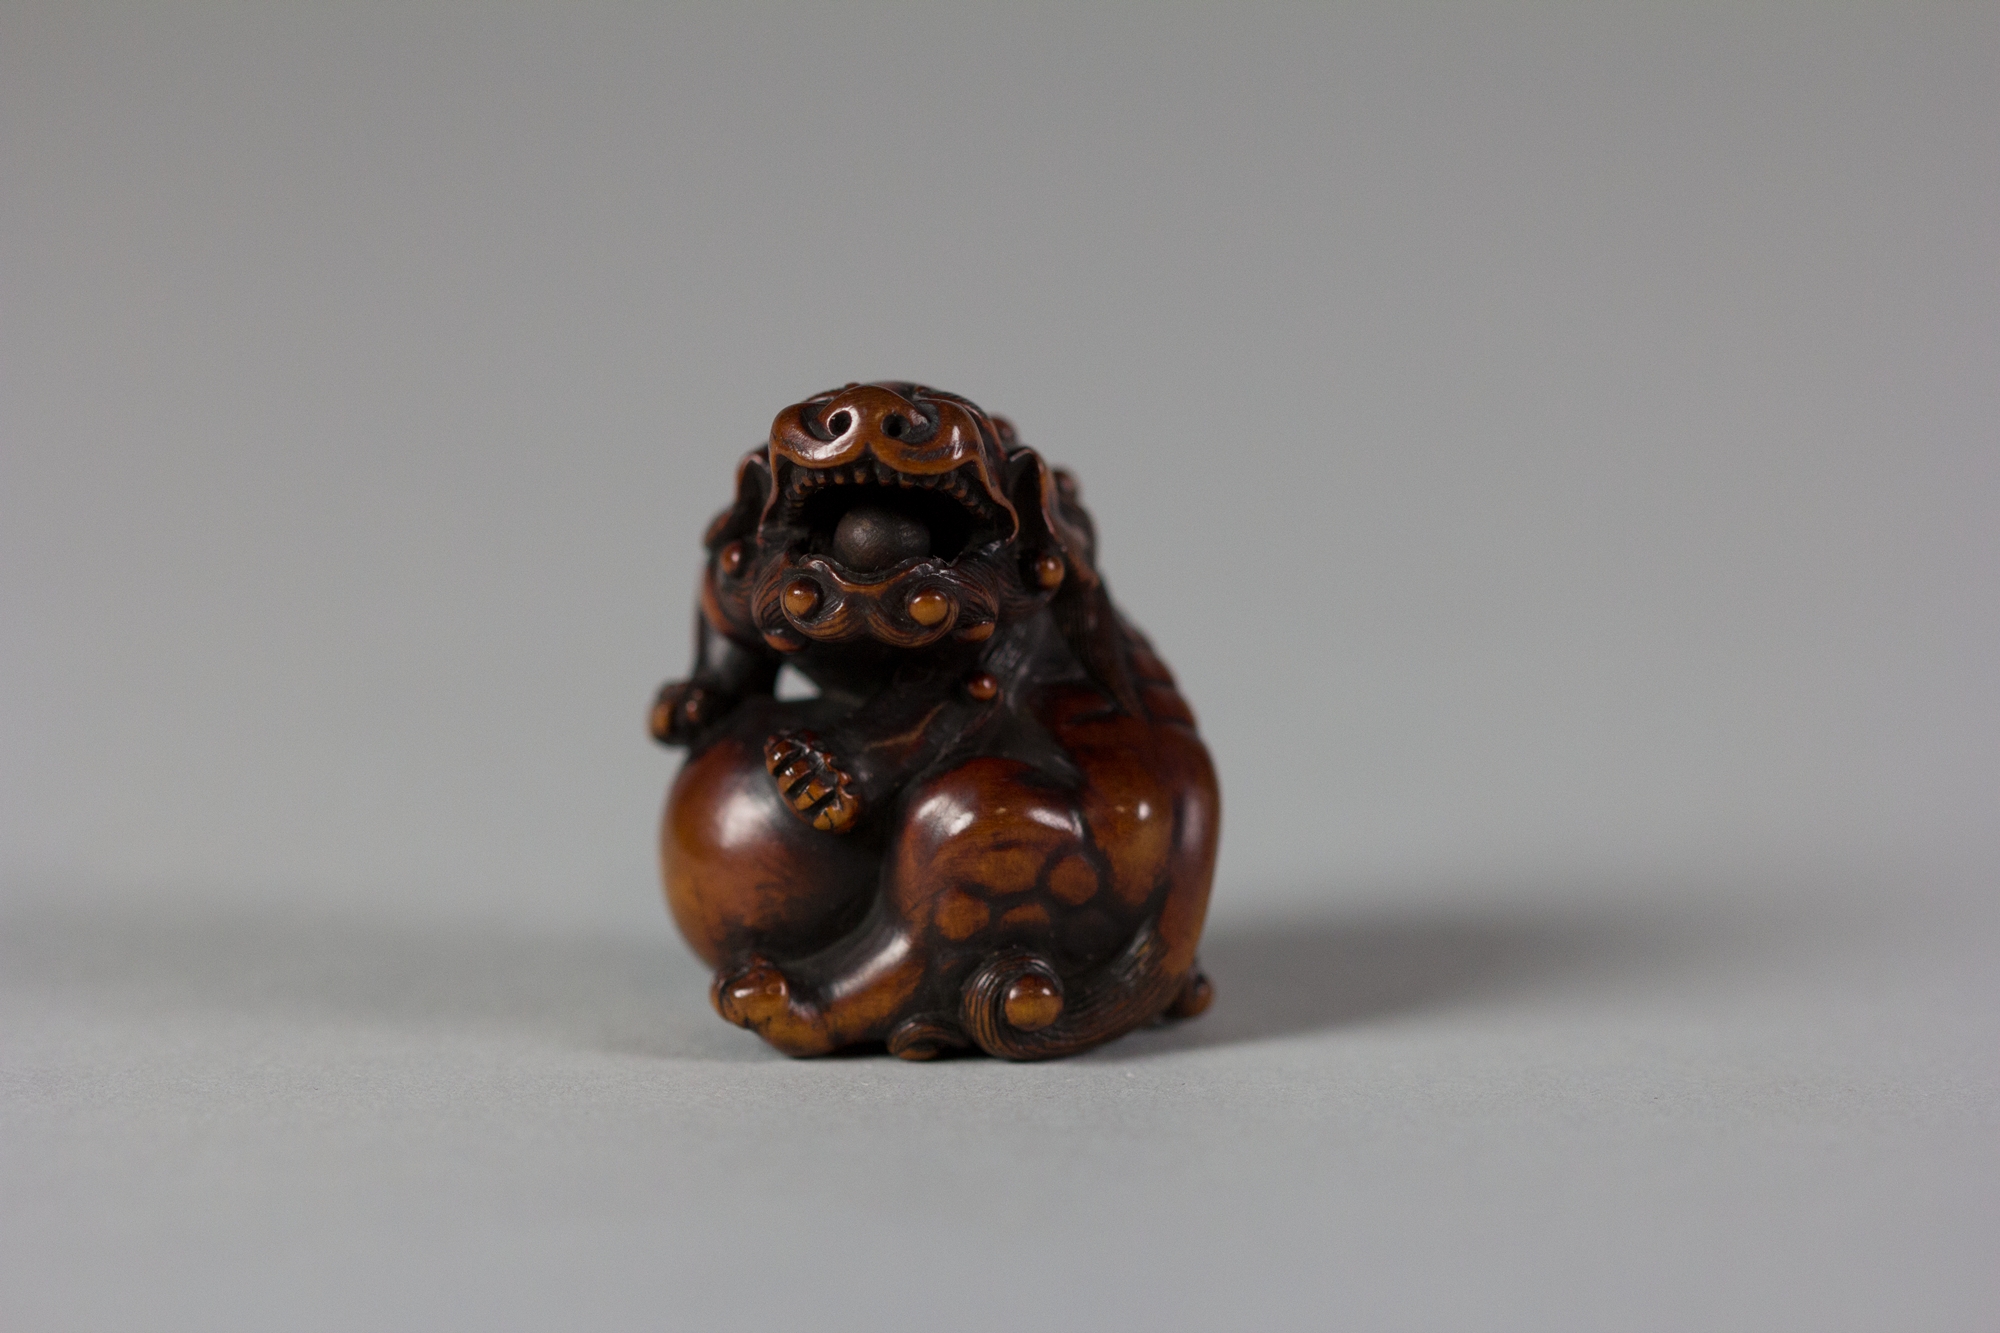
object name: netsuke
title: Netsuke of Lion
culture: japanese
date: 1701-1800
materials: wood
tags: lions